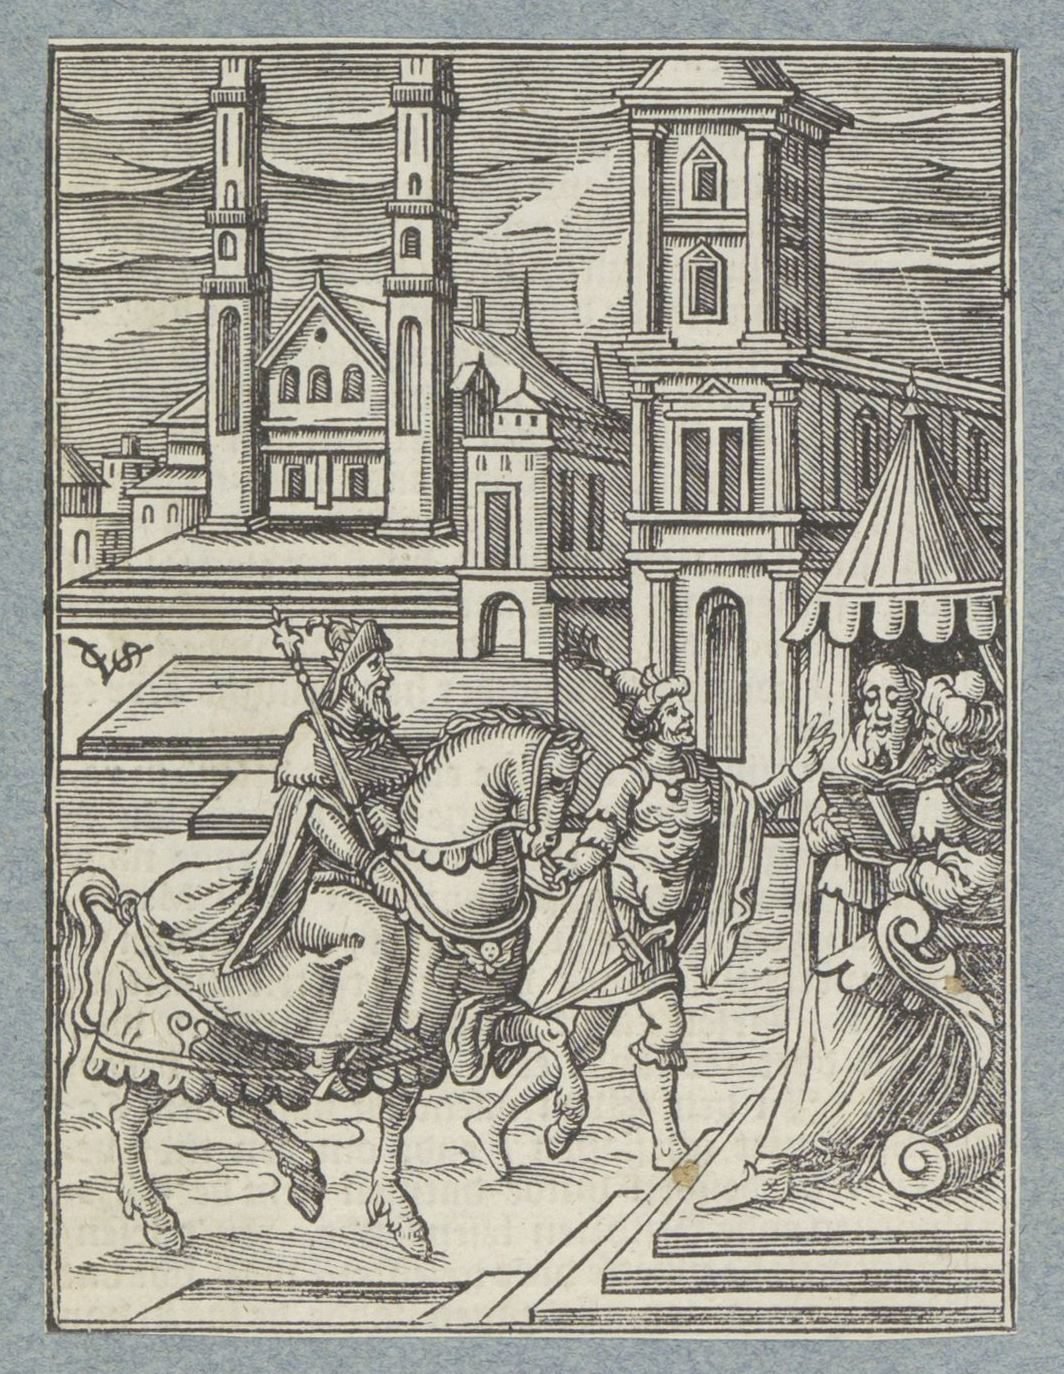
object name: album leaf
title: Haman leidt Mordekai in koningsgewaad en op het paard van de koning over de marktplaats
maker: pieter jacobsz. paets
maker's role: publisher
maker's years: 1587-1667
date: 1645-1646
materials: paper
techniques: letterpress printing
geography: amsterdam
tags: haman's discomfiture: ahasuerus orders the royal robes and his horse to be bestowed on mordecai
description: Ahasveros vraagt aan Haman hoe hij het beste een onderdaan kan eren. Haman antwoordt dat iemand door een van de adelijke rijksgroten van de koning op een paard en in koningsgewaad over het stadsplein gereden zou moeten worden. De prent maakt deel uit van een album.